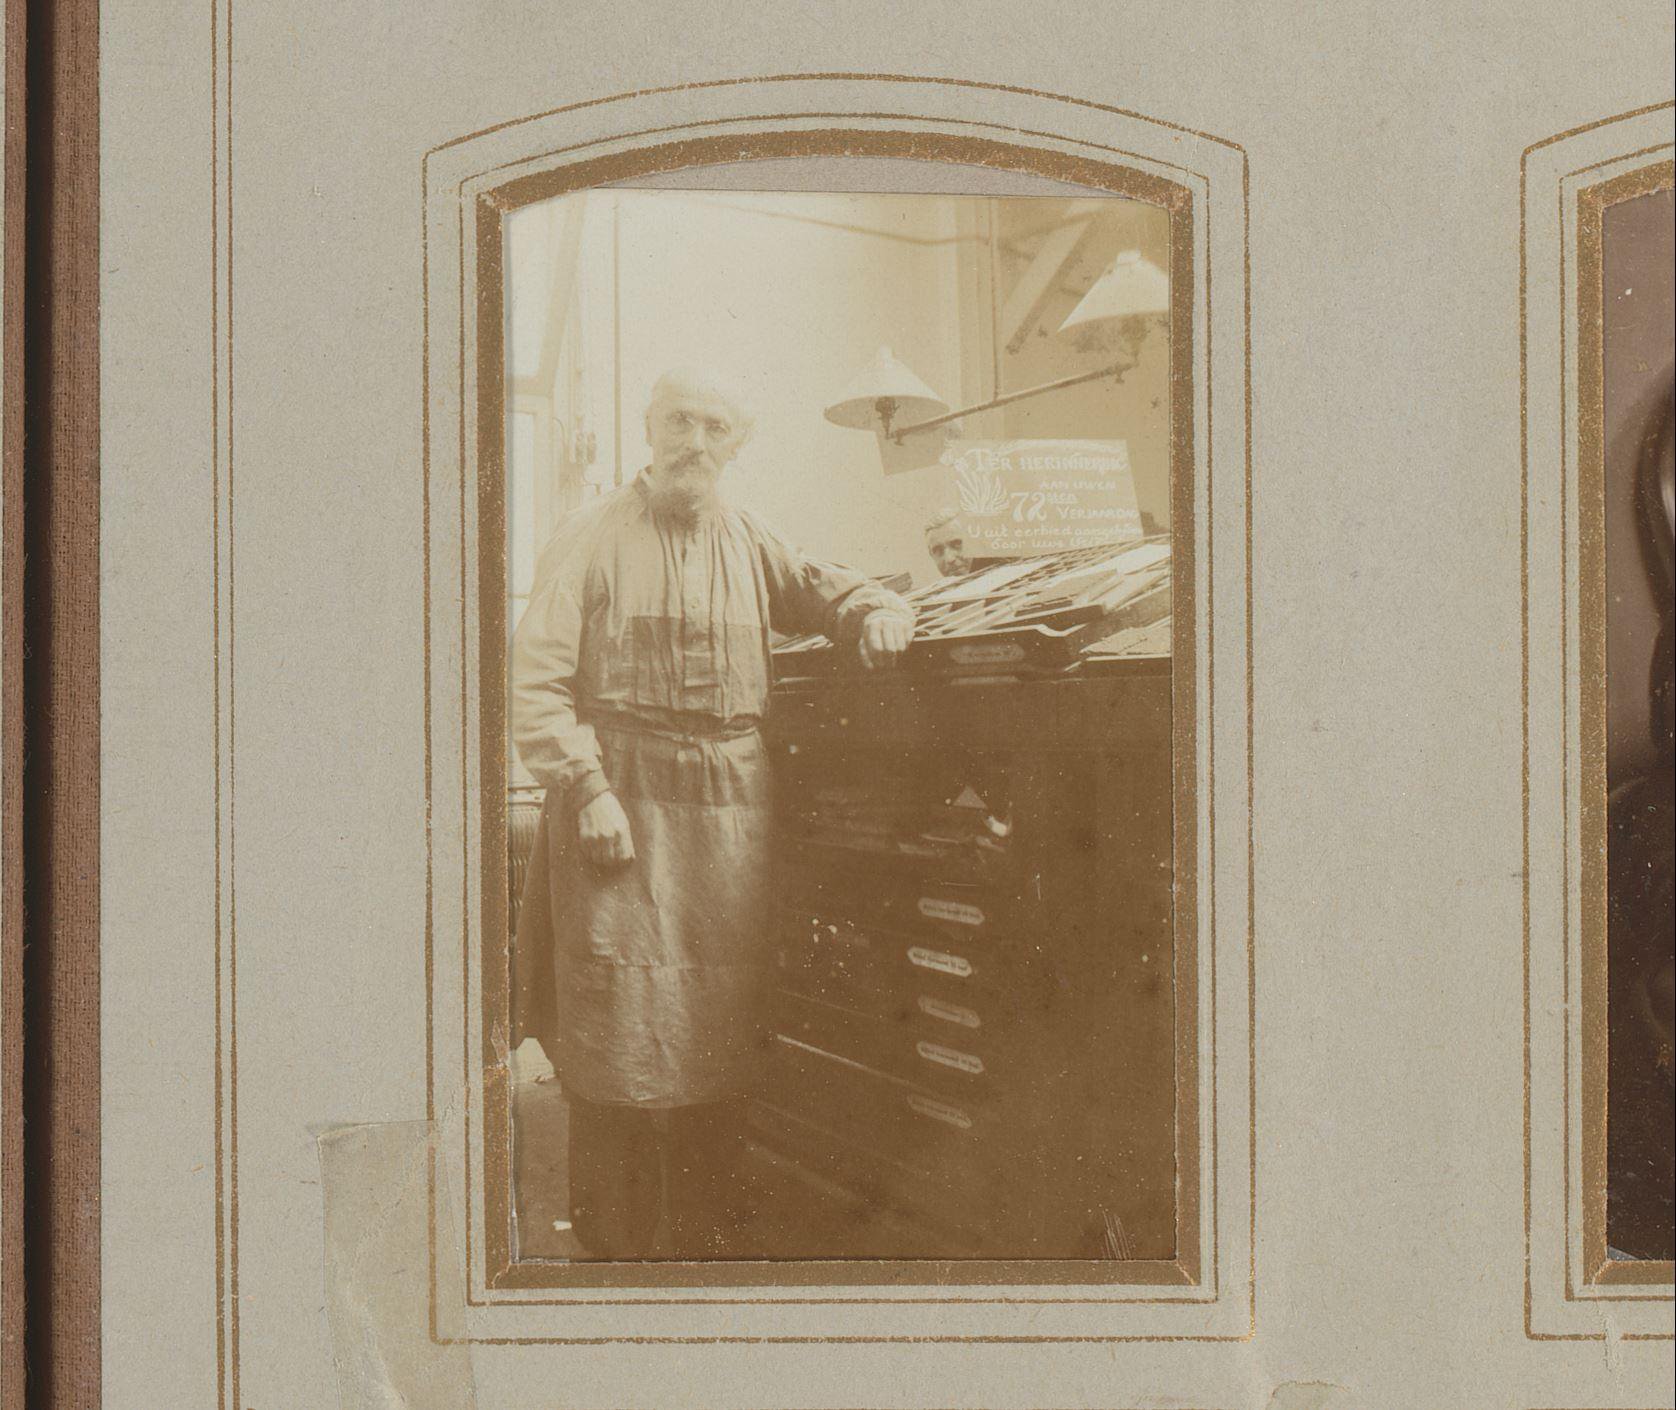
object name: photograph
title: Portret van een man bij een kast met letterbakken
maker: Anonymous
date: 1882-1920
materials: cardboard, photographic support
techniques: gelatin silver print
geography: netherlands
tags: historical persons, printing press (+ in workshop, laboratory)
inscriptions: name: ‘W. Rynders’